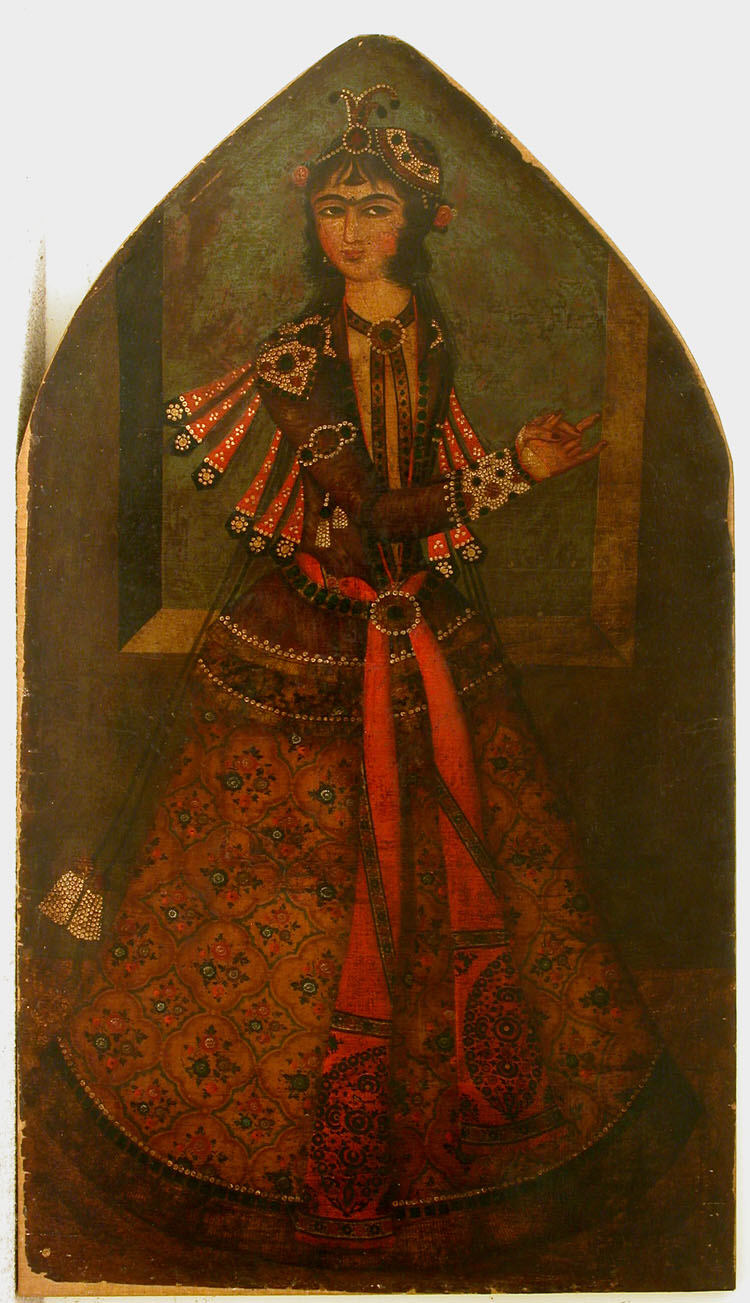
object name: painting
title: Dancer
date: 1801-1833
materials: canvas, gold, oil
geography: iran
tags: women,dancers